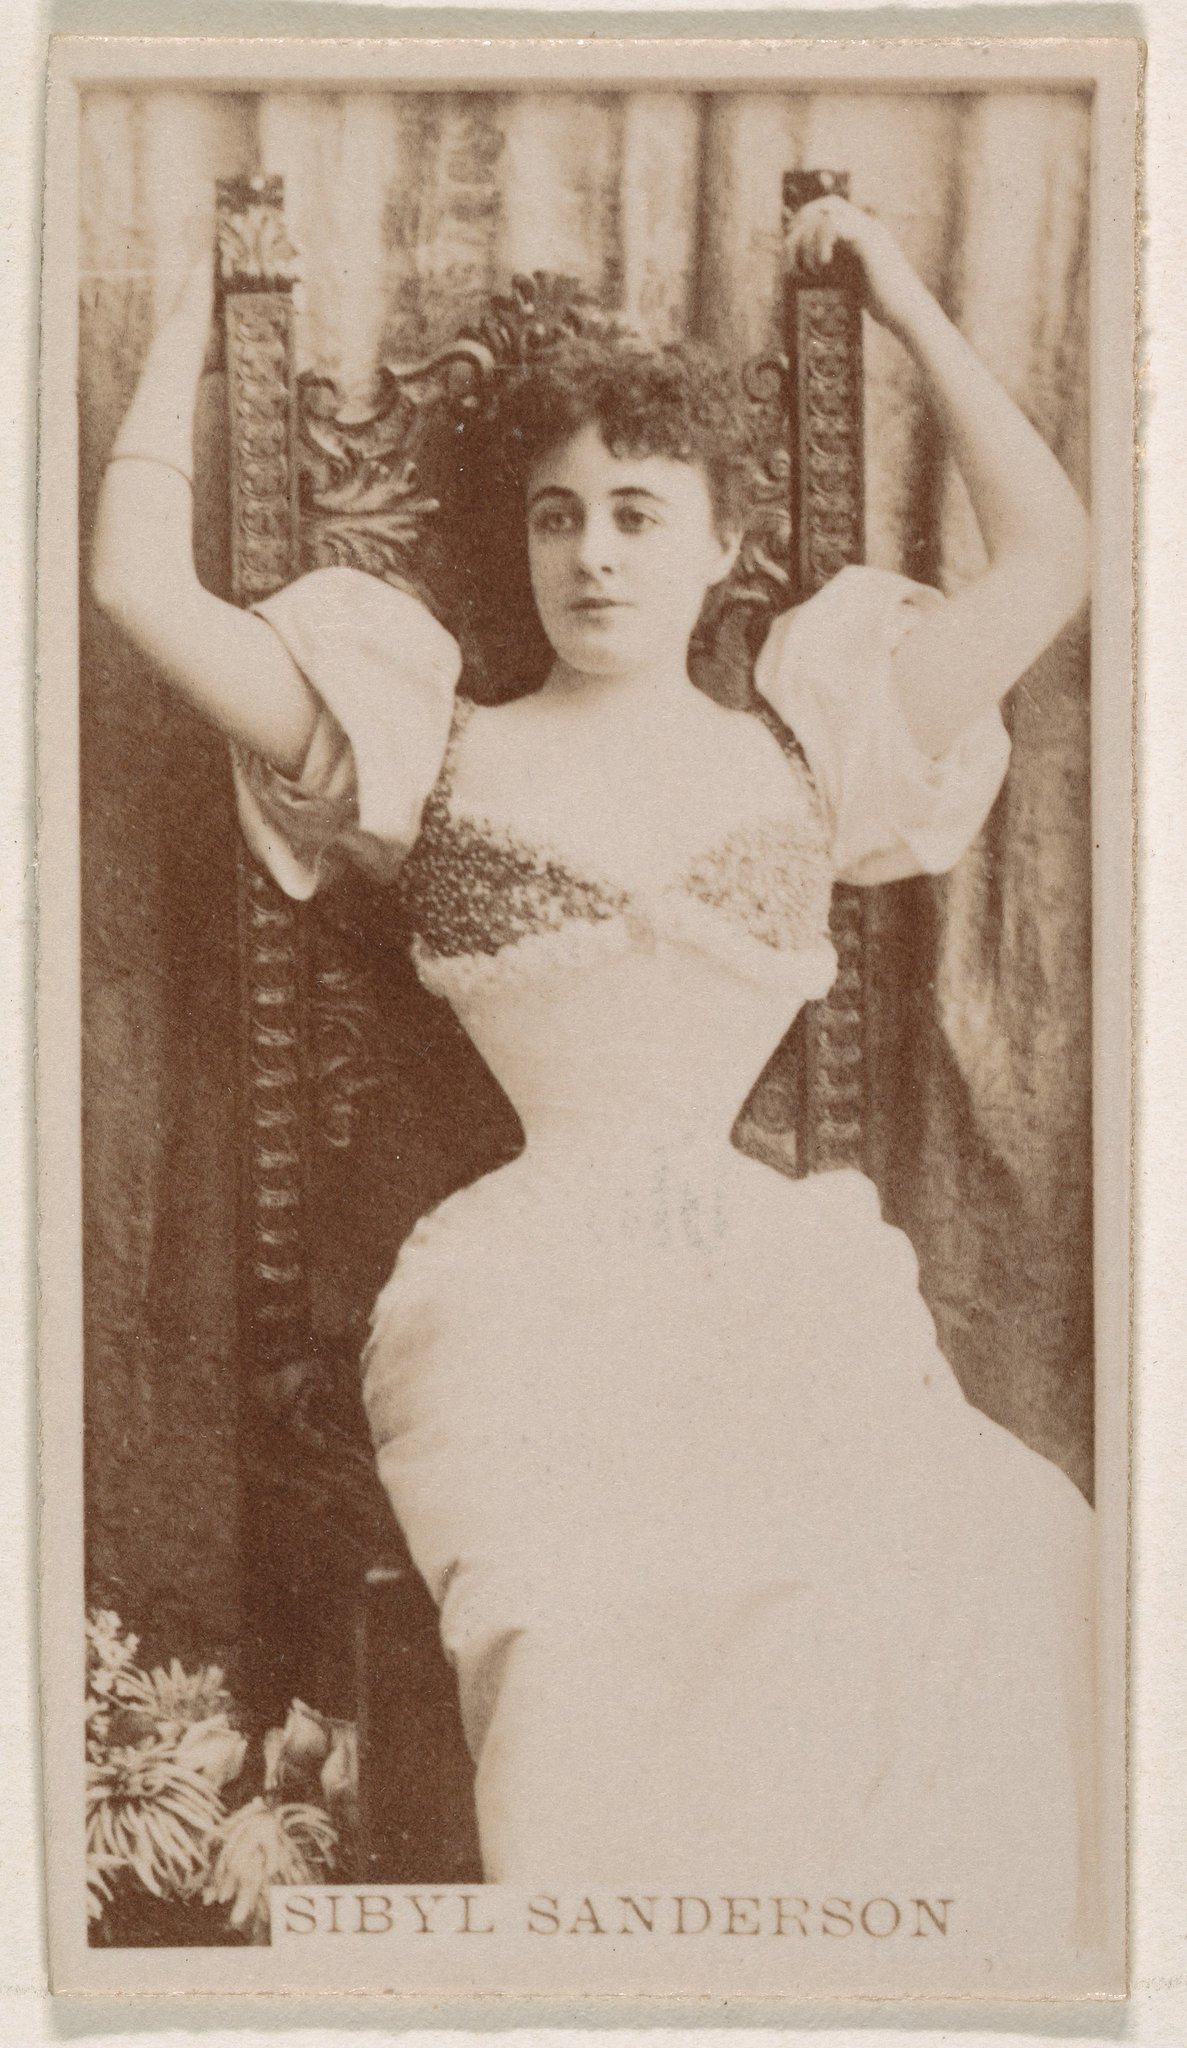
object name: photograph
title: Sibyl Anderson, from the Actresses series (N245) issued by Kinney Brothers to promote Sweet Caporal Cigarettes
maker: kinney brothers tobacco company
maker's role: publisher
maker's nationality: american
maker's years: 1869-2011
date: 1890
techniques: albumen silver print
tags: portraits,women,actresses